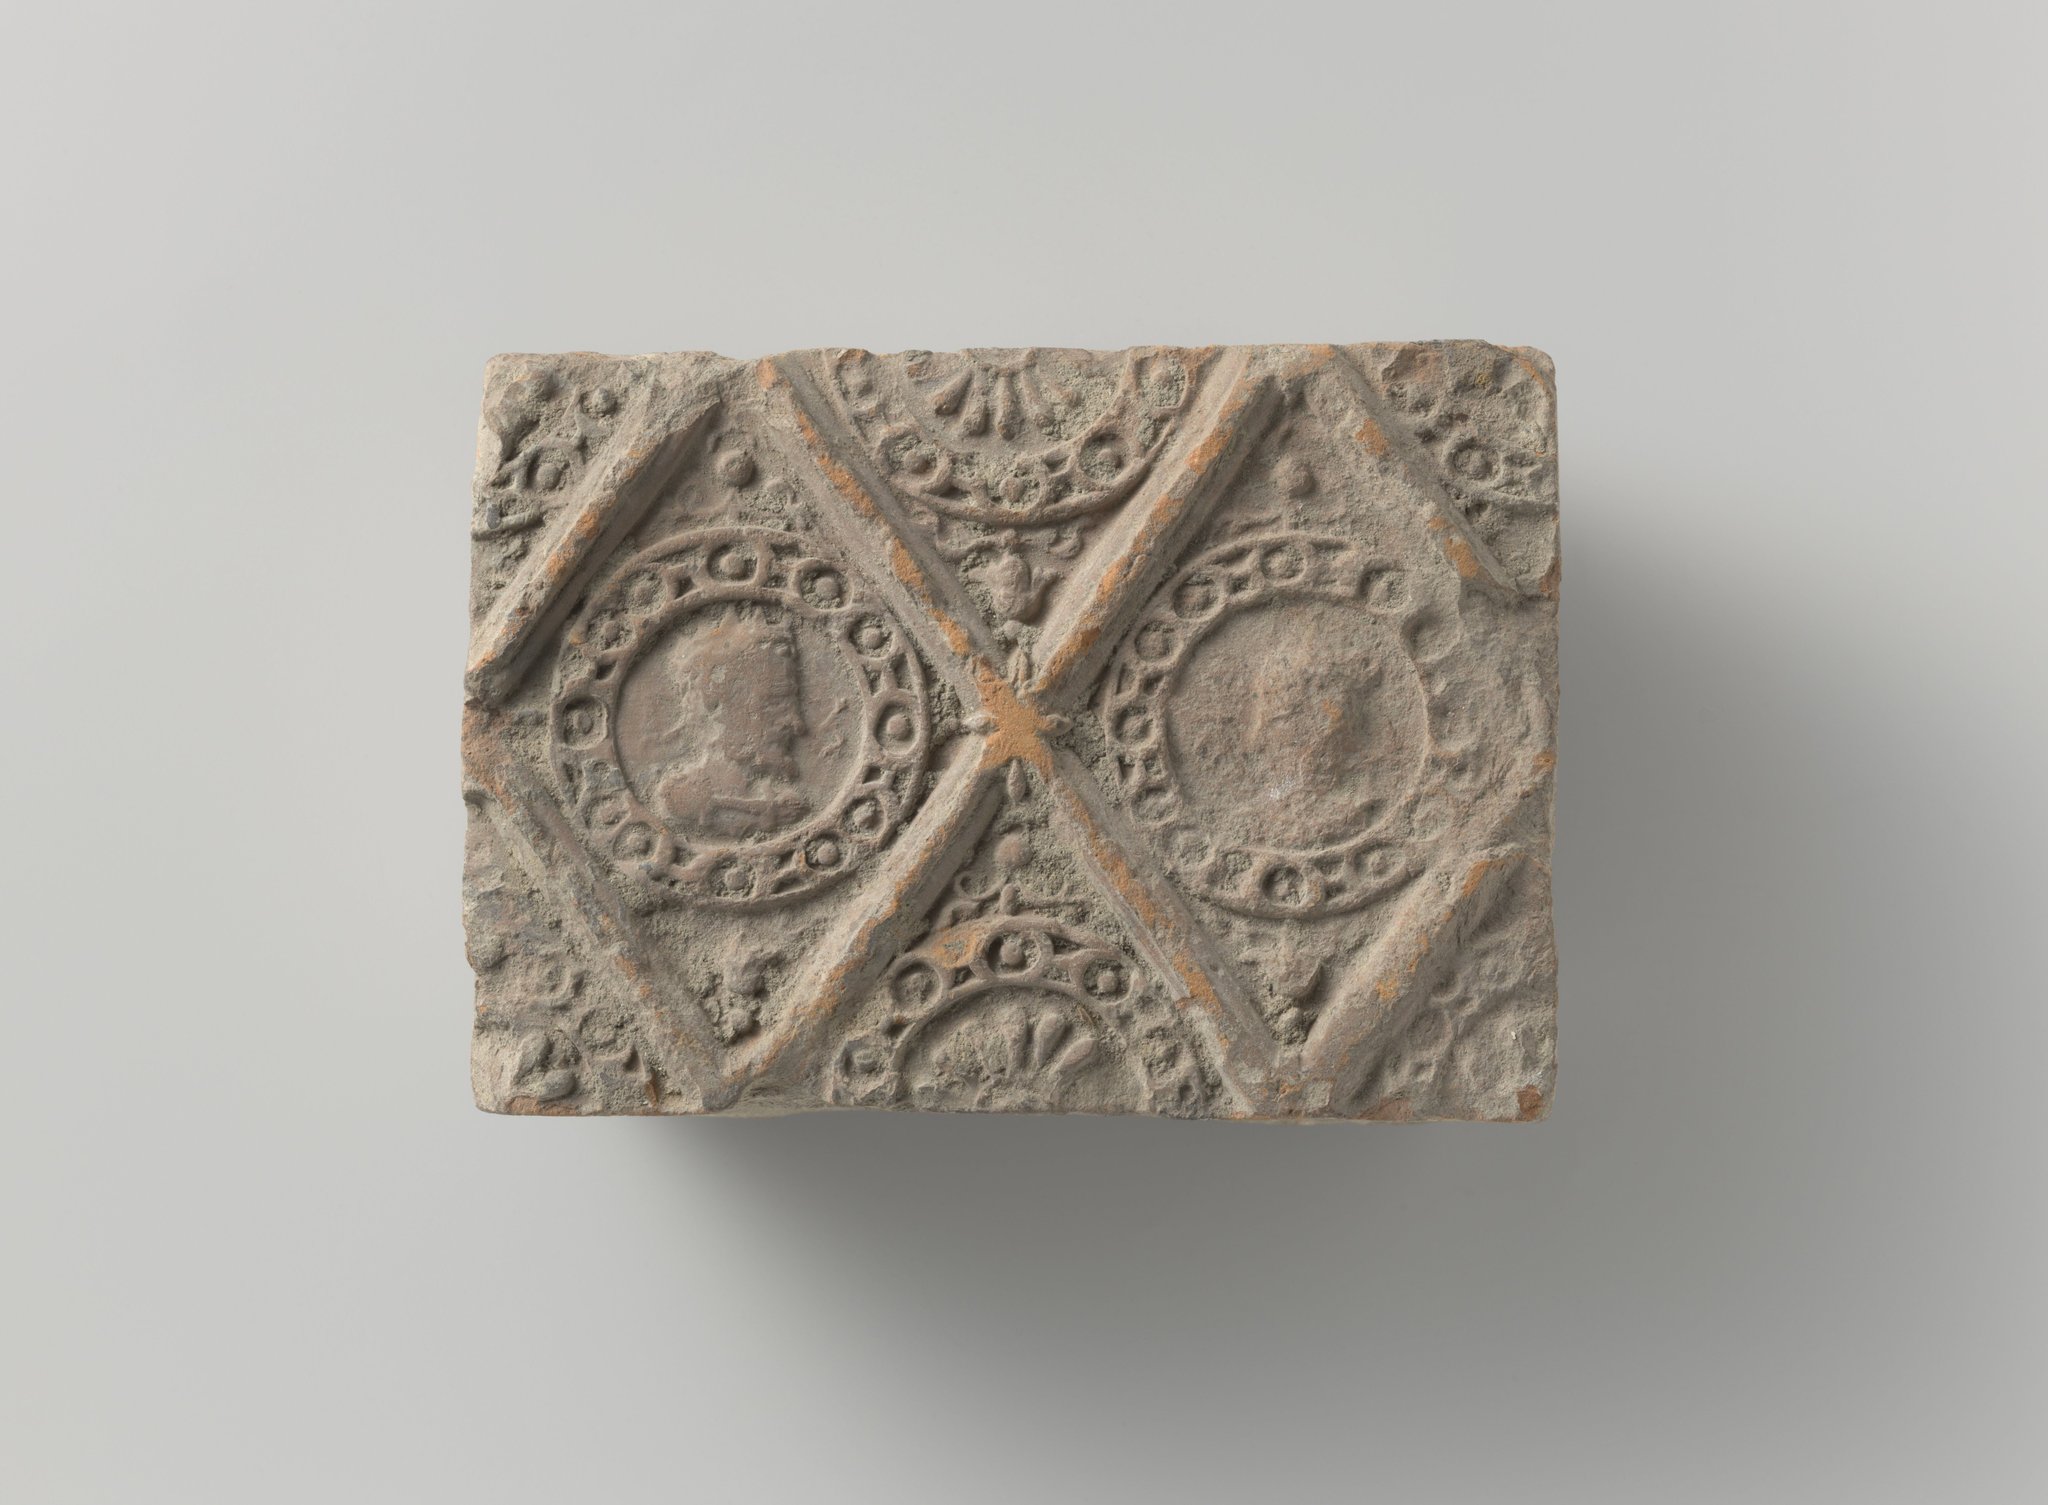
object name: hearthstone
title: Haardsteen met voorstelling van twee portretmedaillons, geplaatst in twee ruiten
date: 1400-1950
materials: earthenware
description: Haardsteen van onverglaasde rode aarde, versierd met ruiten, waarin portretmedaillons in laag reliëf.